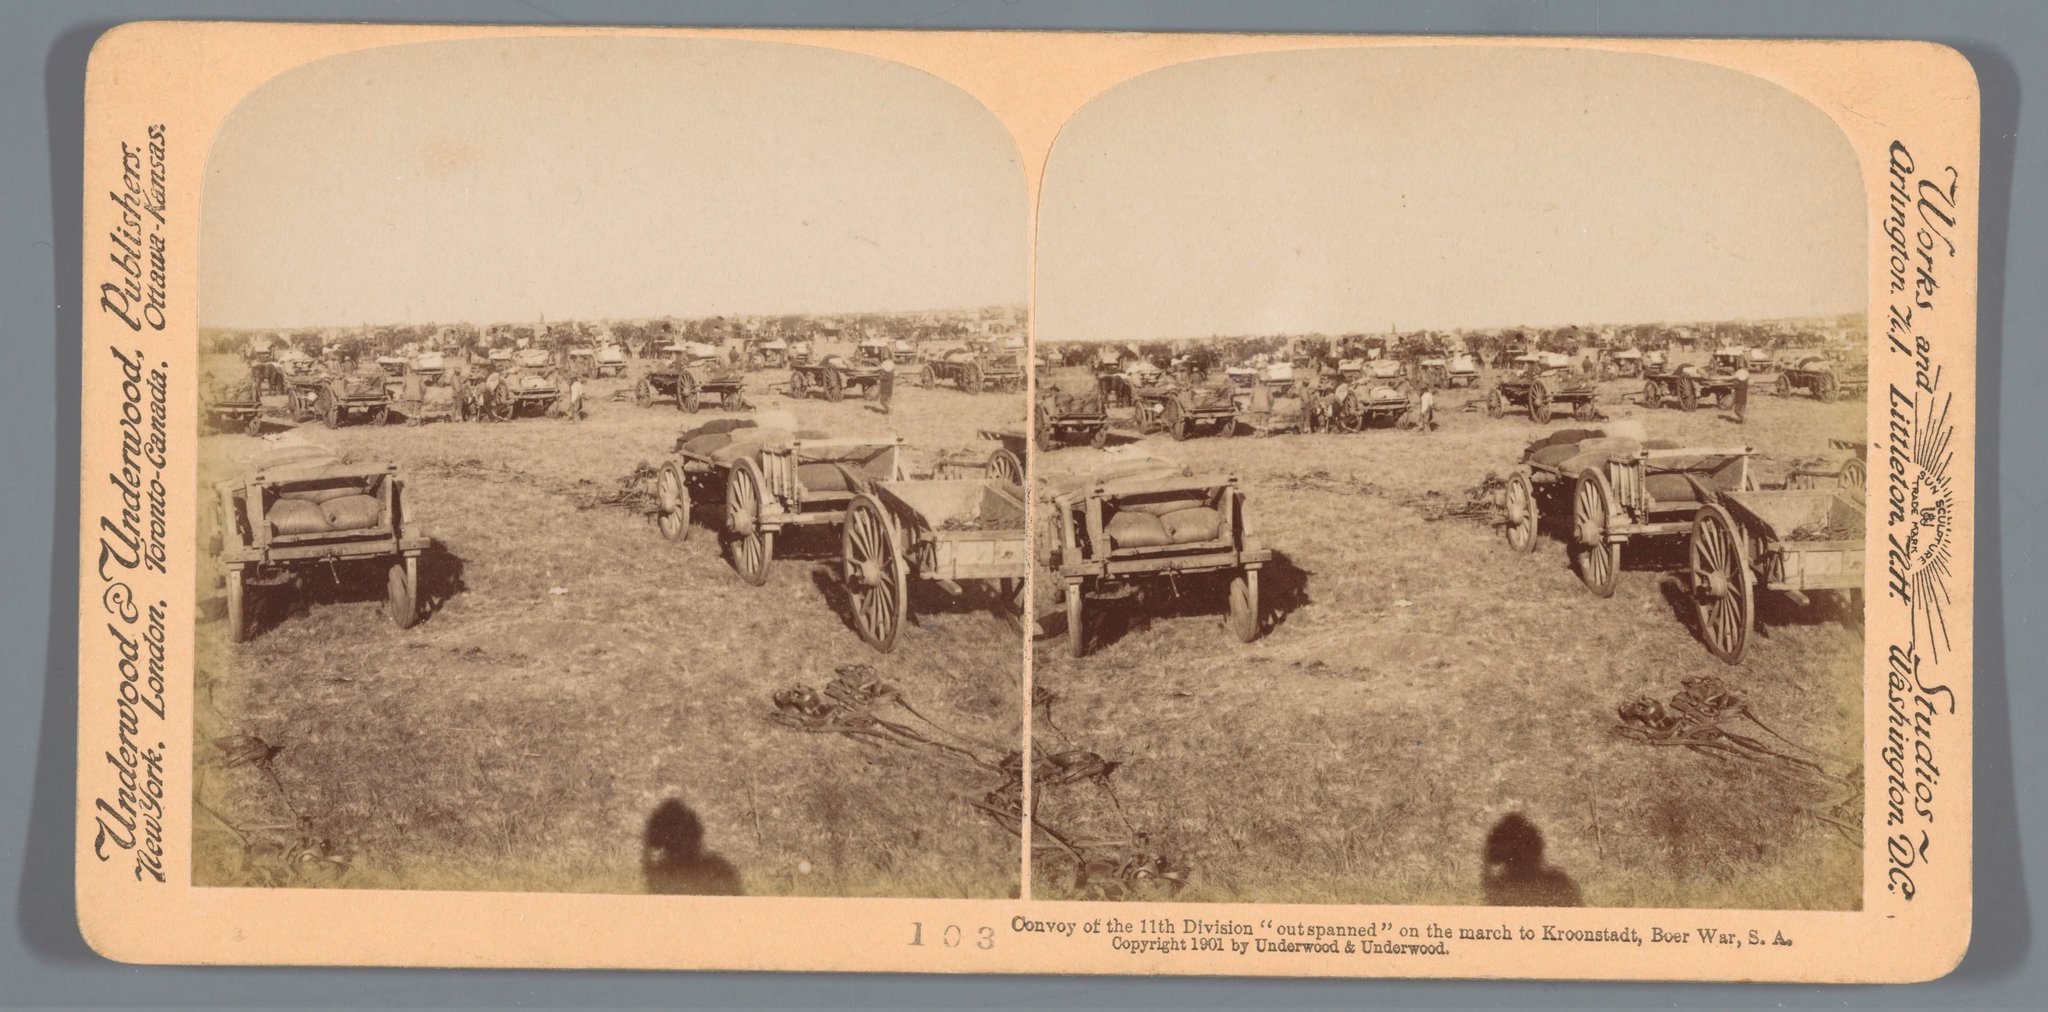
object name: stereograph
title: Gezicht op transportkarren onderweg naar Kroonstad, Zuid-Afrika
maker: Anonymous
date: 1901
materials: cardboard, paper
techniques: albumen print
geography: south africa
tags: army 'en route', troop movements, transportation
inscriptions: inscription, number: ‘103’, copyright notice: ‘Copyright 1901 by Underwood & Underwood.’, inscription: ‘Works and Studios ~/ Arlington, N.J. Littleton, N.H. Washington, D.C.’